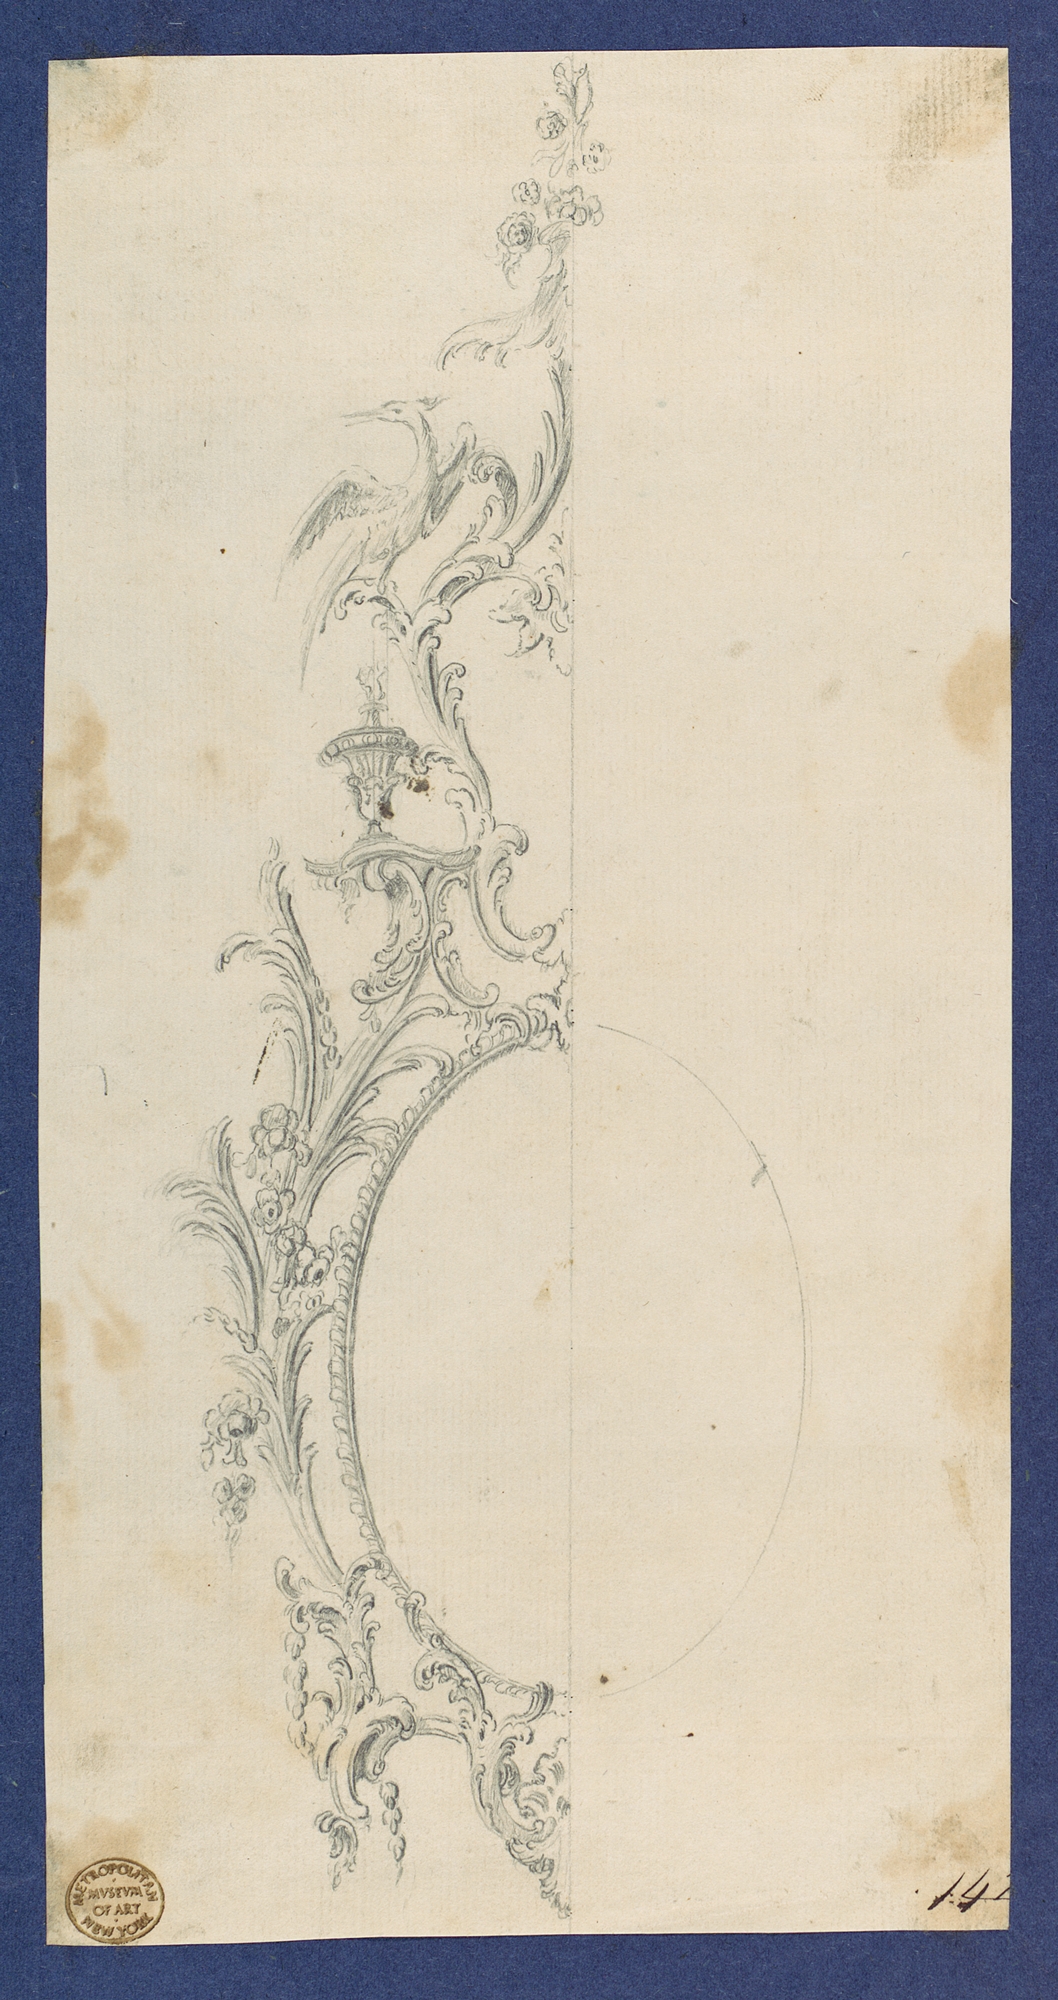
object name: drawing ornament architecture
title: Pier Glass Frame, in Chippendale Drawings, Vol. I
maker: thomas chippendale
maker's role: artist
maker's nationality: british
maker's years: 1718-1779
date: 1753-1762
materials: graphite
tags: birds,ornament